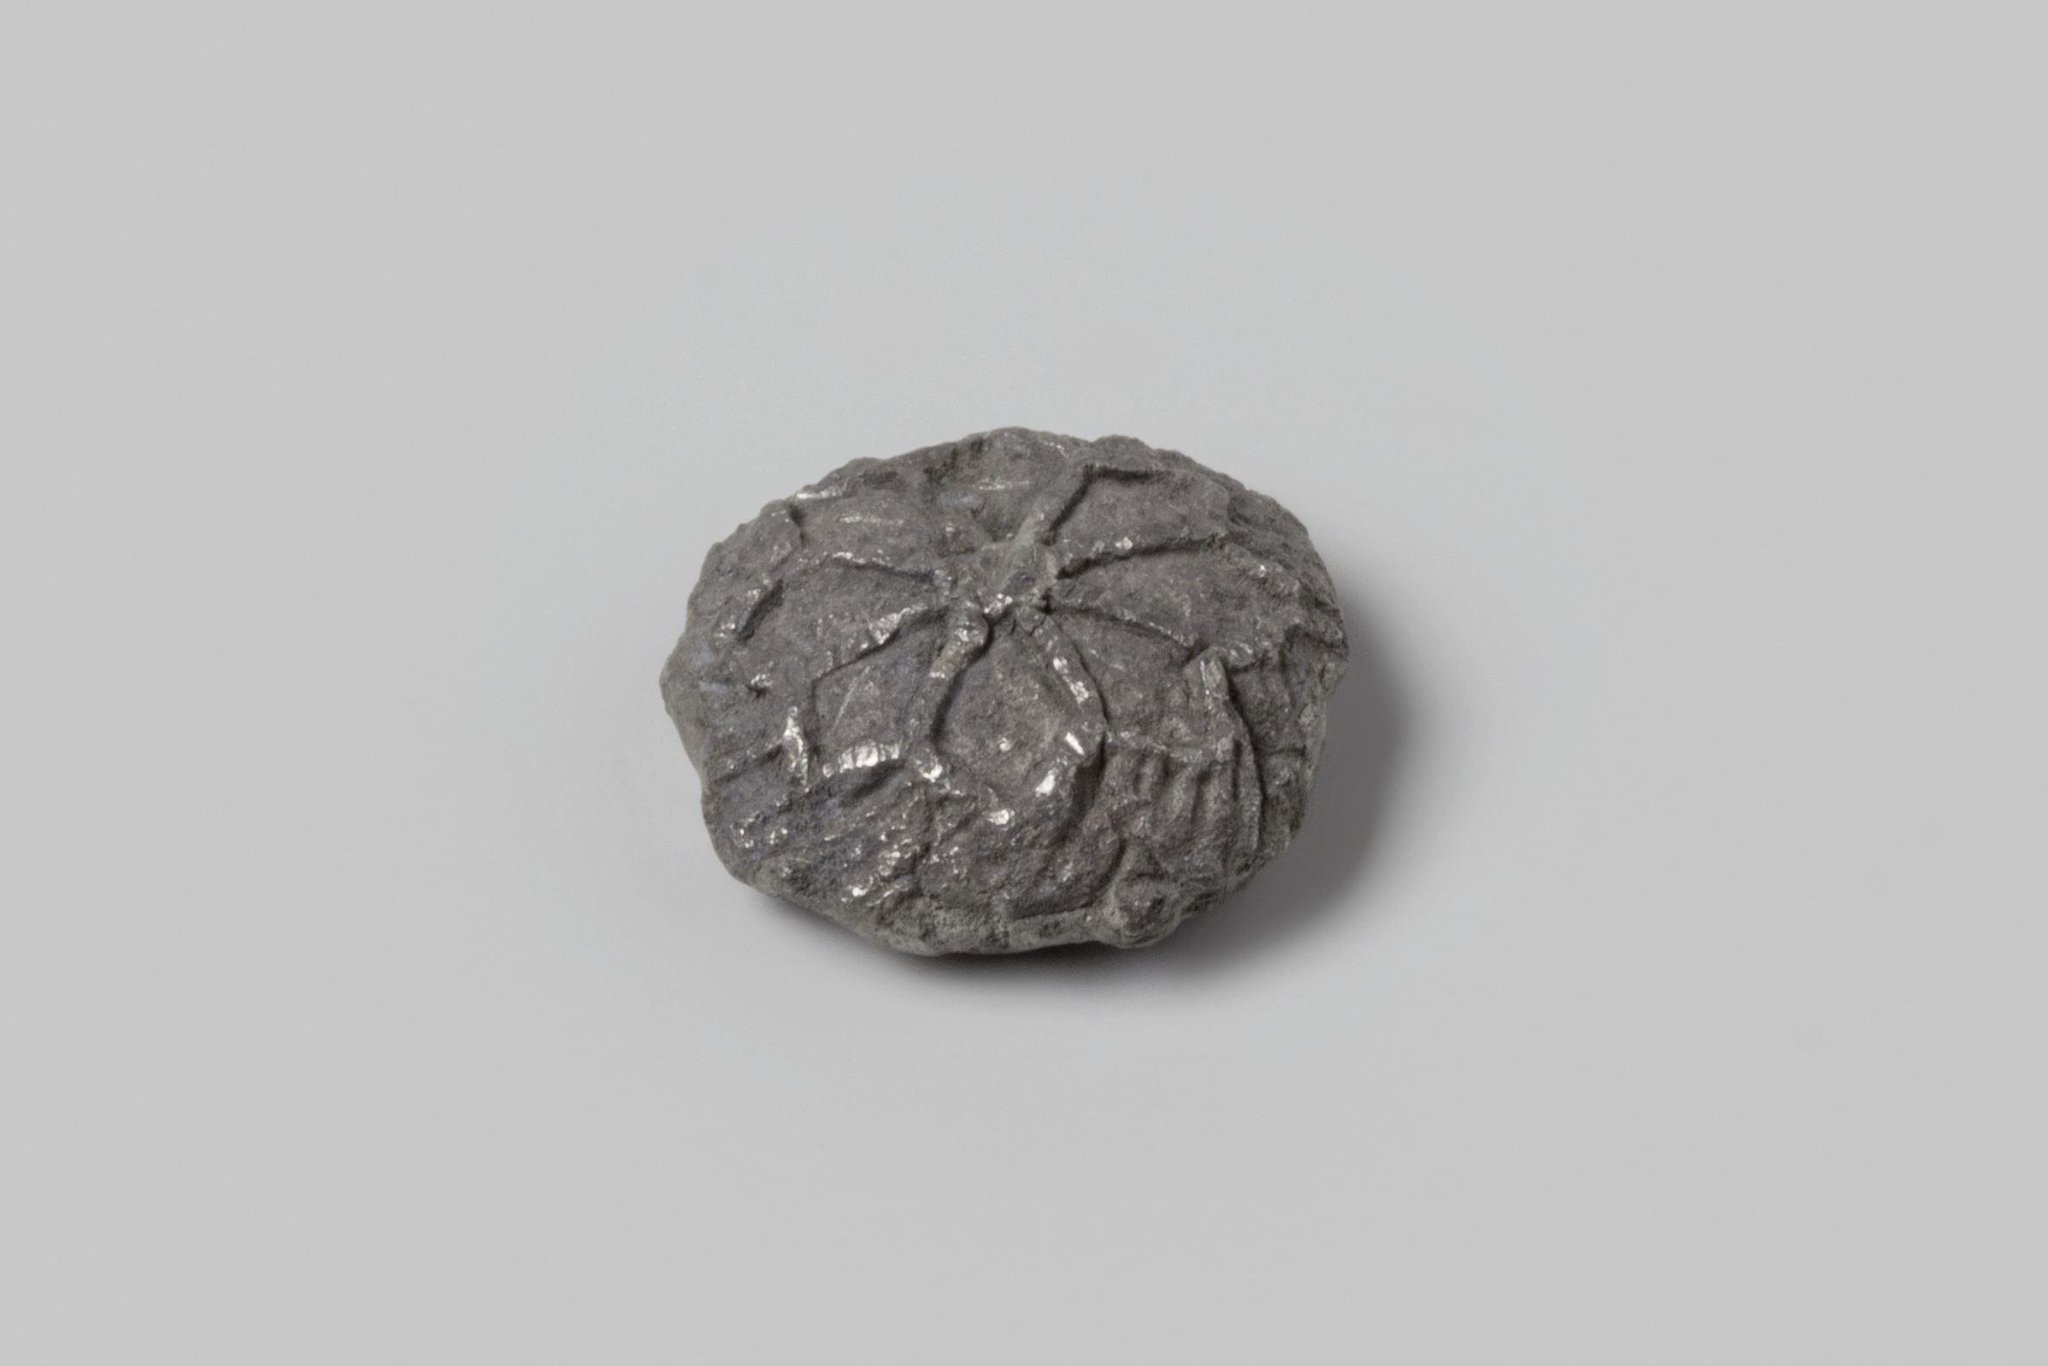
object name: button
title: Knoop uit het wrak van de Oost-Indiëvaarder Hollandia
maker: Anonymous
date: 1700-1743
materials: tin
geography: netherlands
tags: verenigde oostindische compagnie, hollandia (schip), annet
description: Knoop. (1) domed, relieved flower-head motif (1.4d, 0.5h), flat base, shank broken